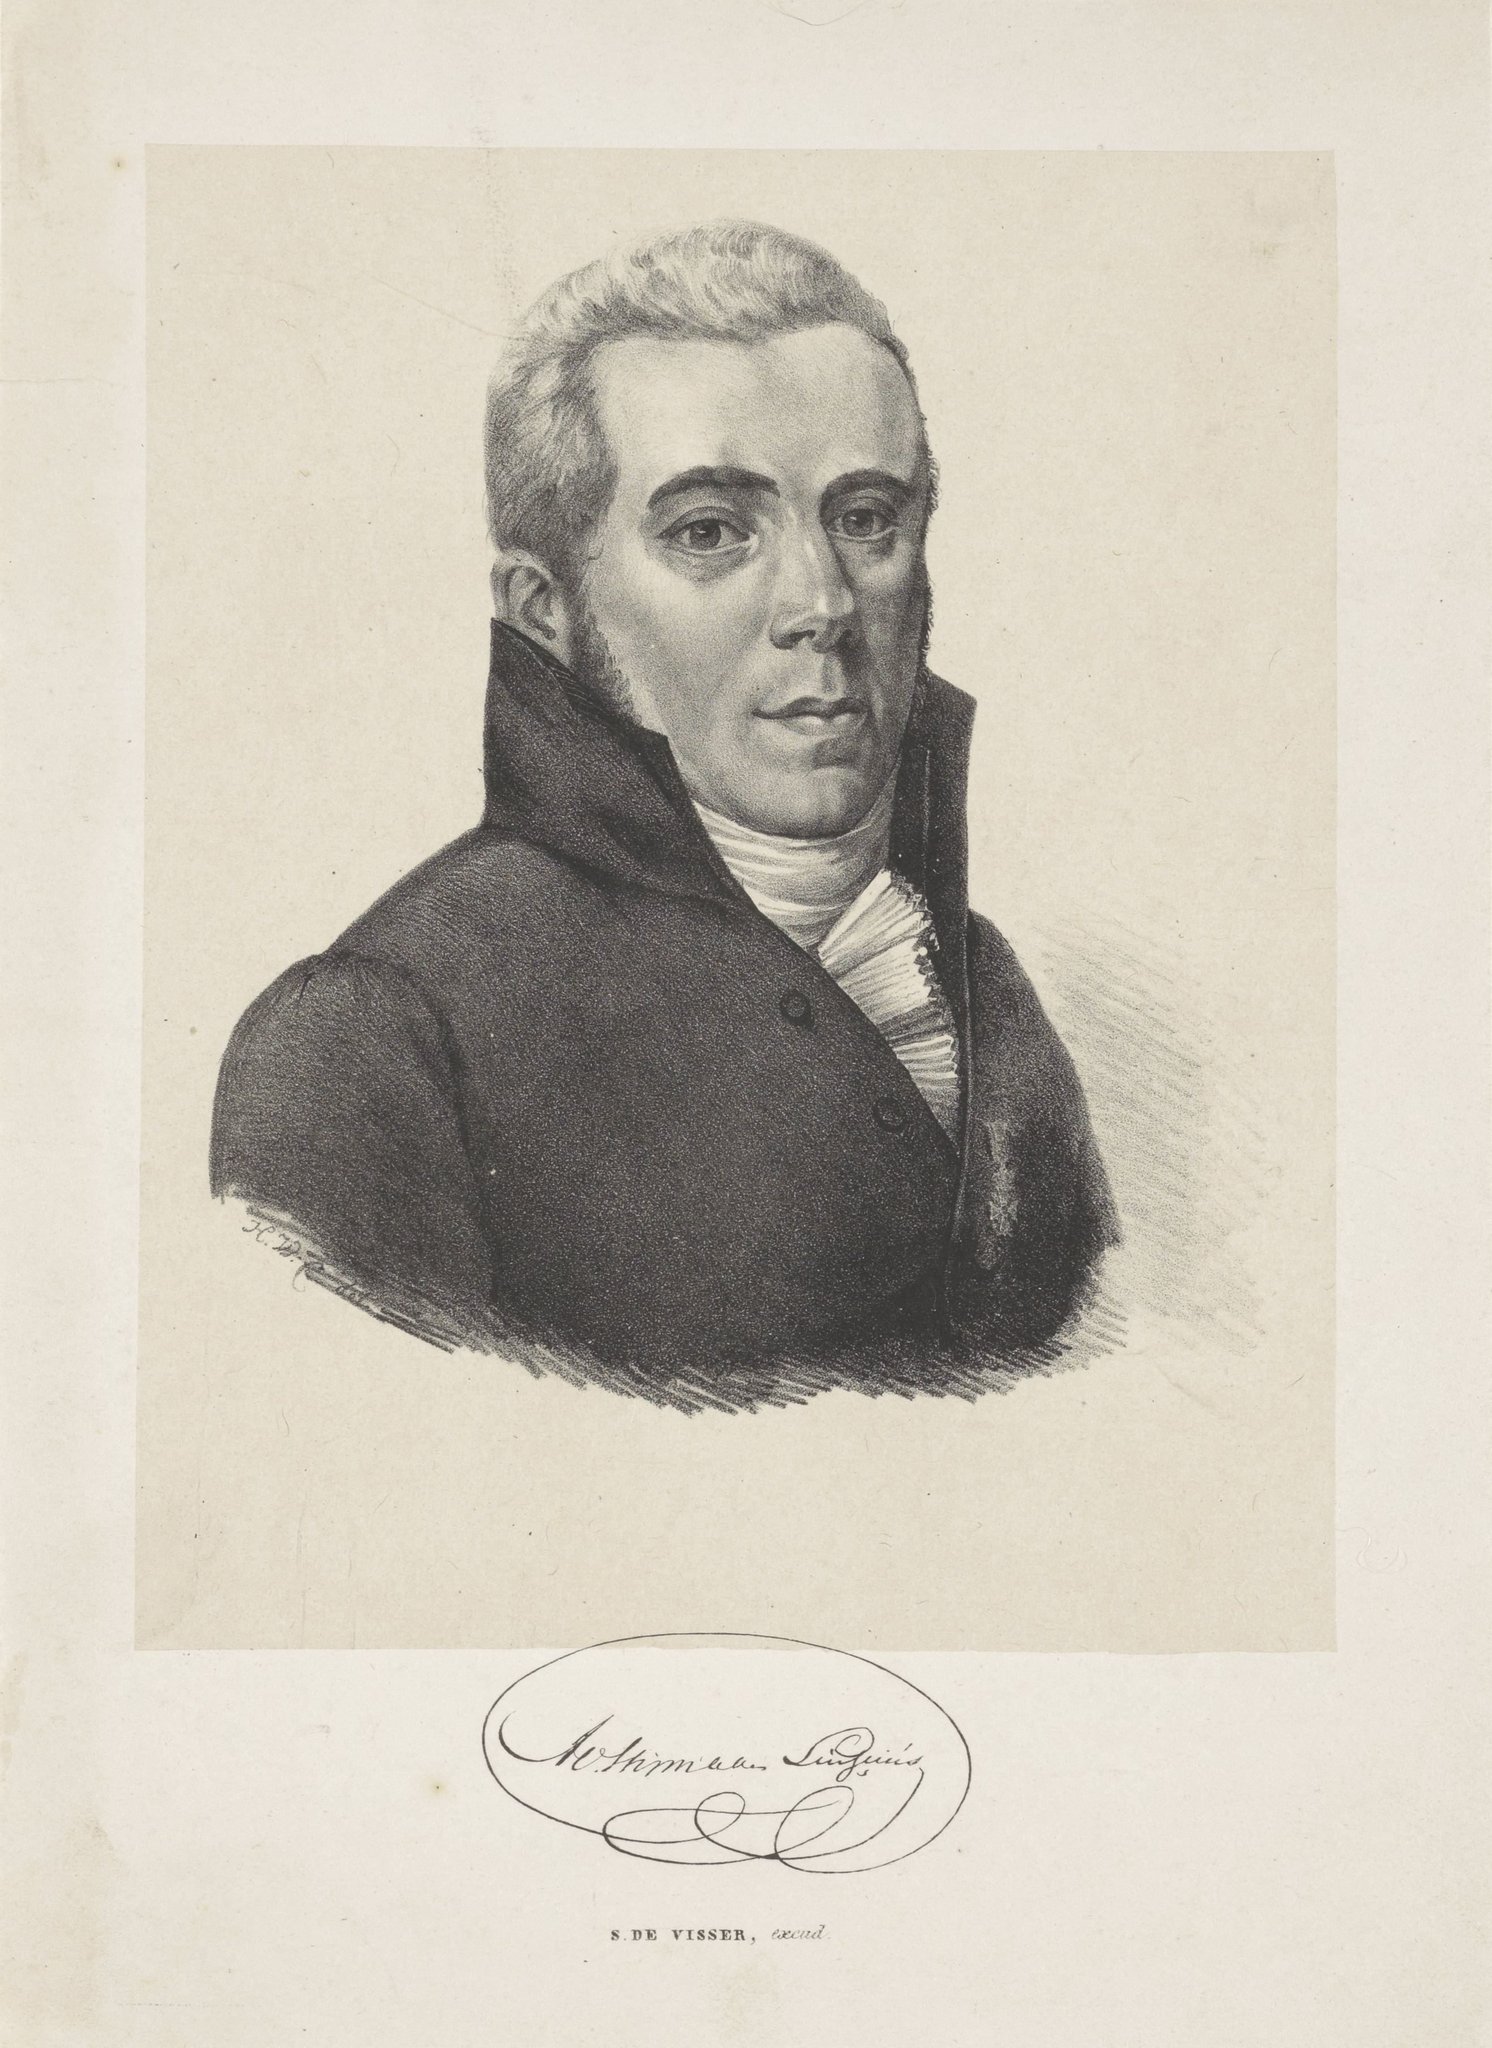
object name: print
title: Portret van Abraham van Stipriaan Luïscius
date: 1829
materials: paper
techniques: lithograph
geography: amsterdam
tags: historical persons (+ head (and shoulders) (portrait)), knighthood order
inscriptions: collector's mark: Lugt 2228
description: De geportretteerde draagt een ridderorde op zijn borst en een hoge opstaande kraag. Daaronder draagt hij een bef met plooien.